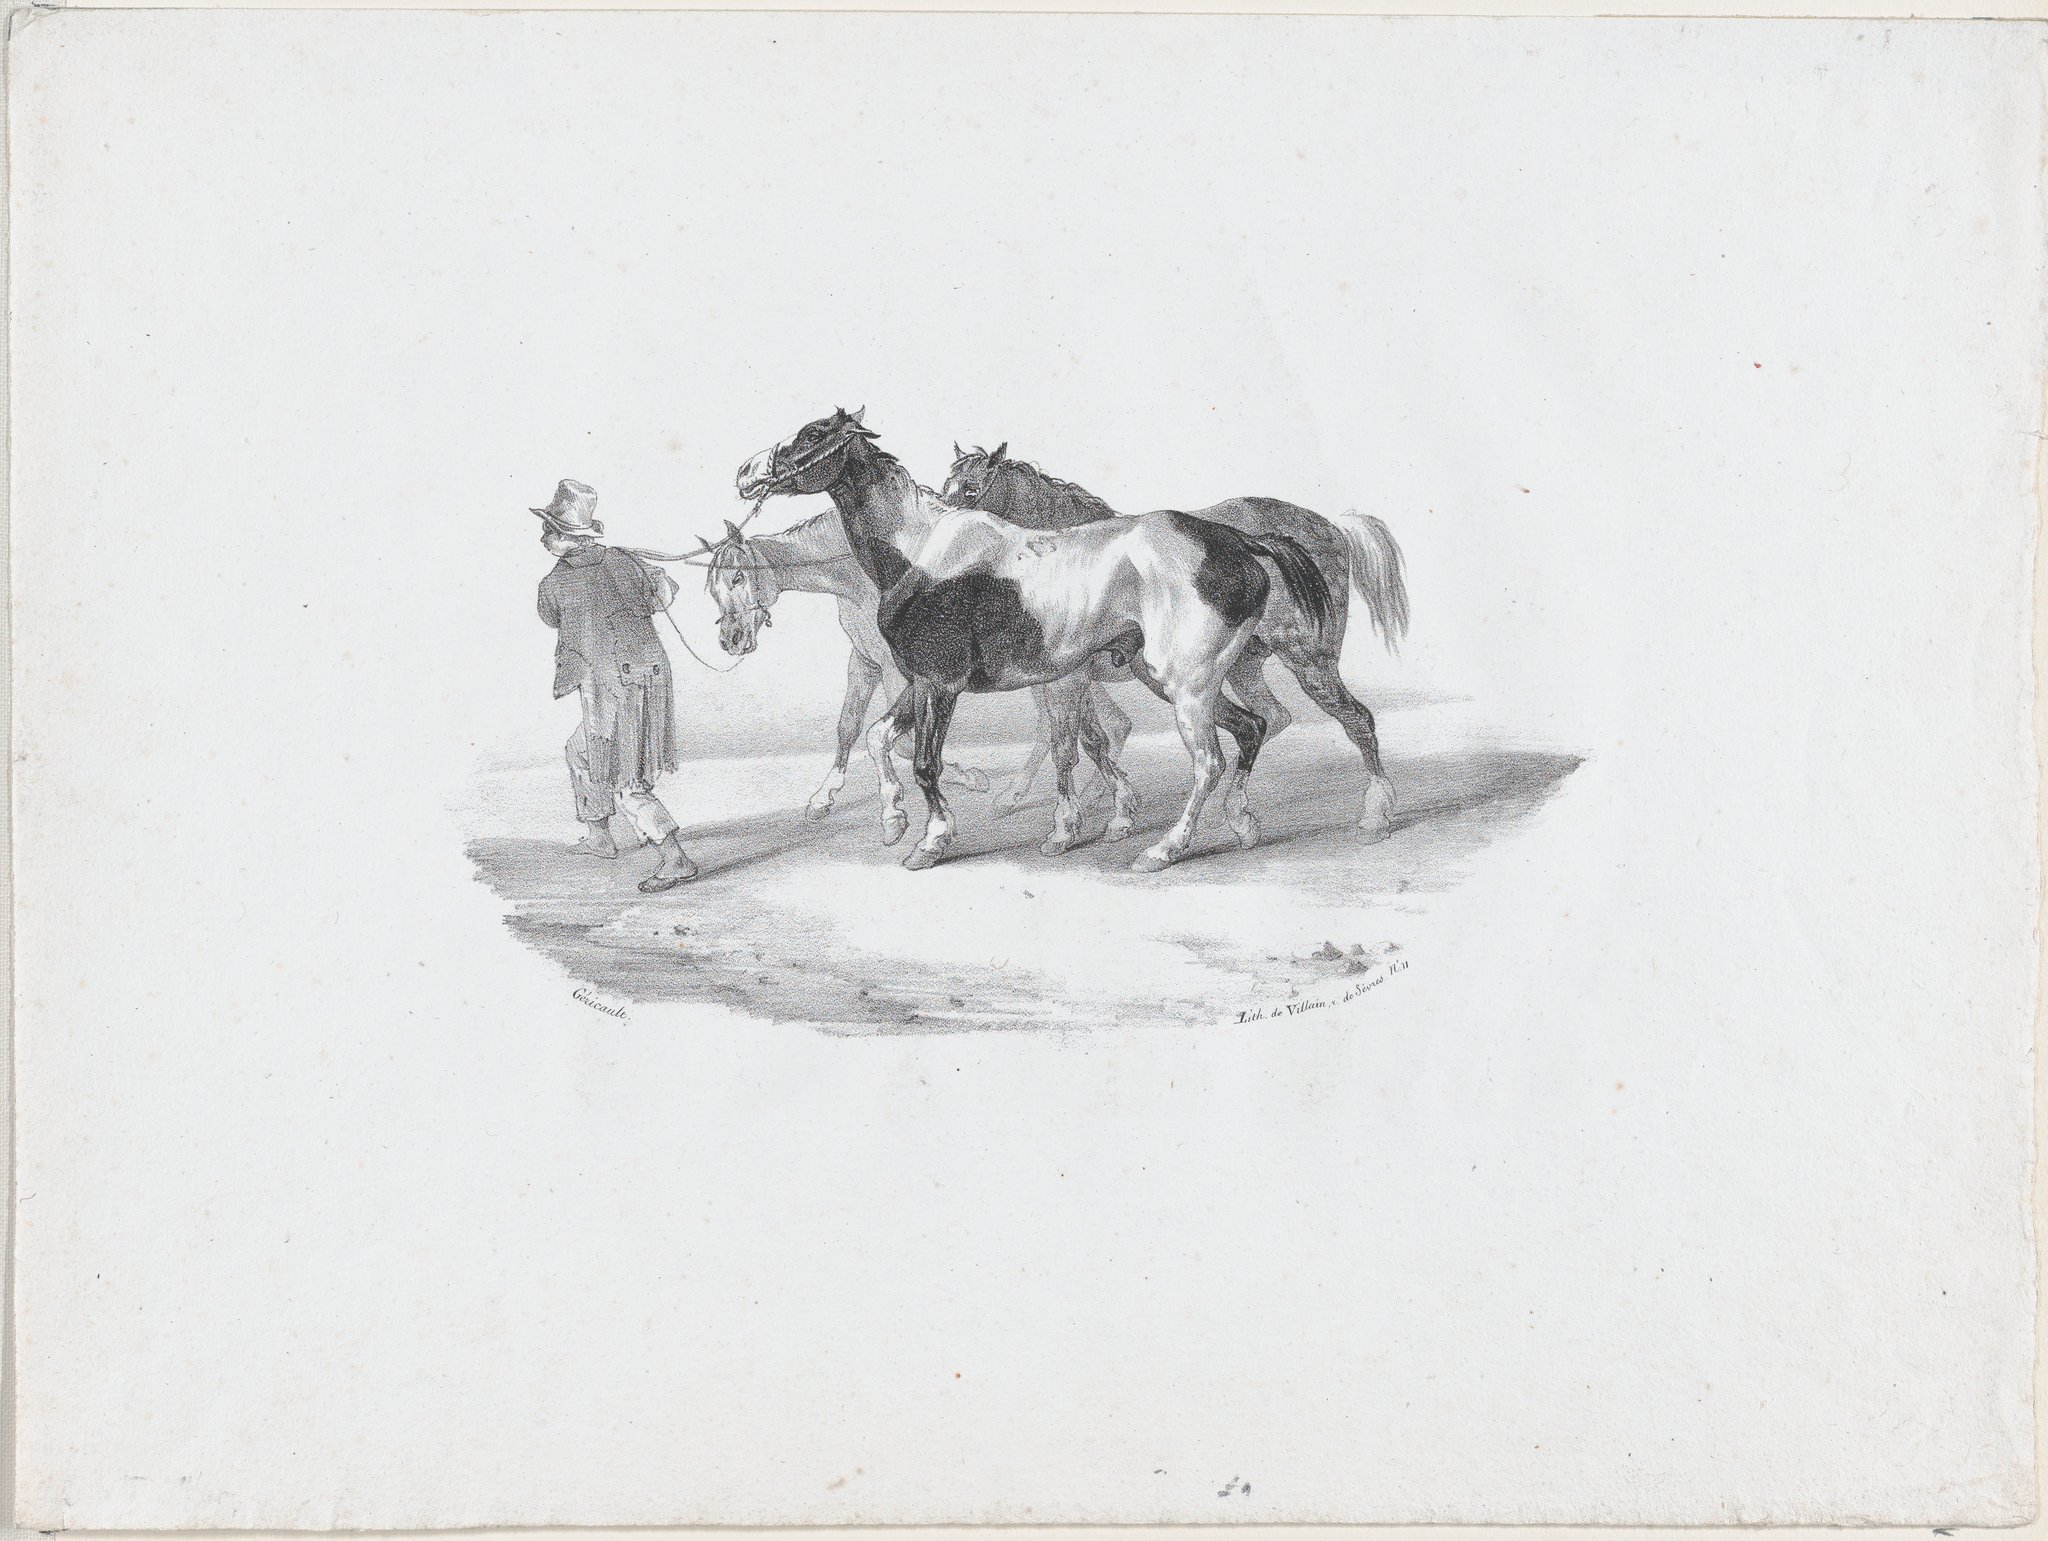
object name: print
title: Three Horses Led by a Groom to be Skinned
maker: jean louis andré théodore géricault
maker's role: artist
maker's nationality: french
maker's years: 1791-1824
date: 1823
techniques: lithograph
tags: horses